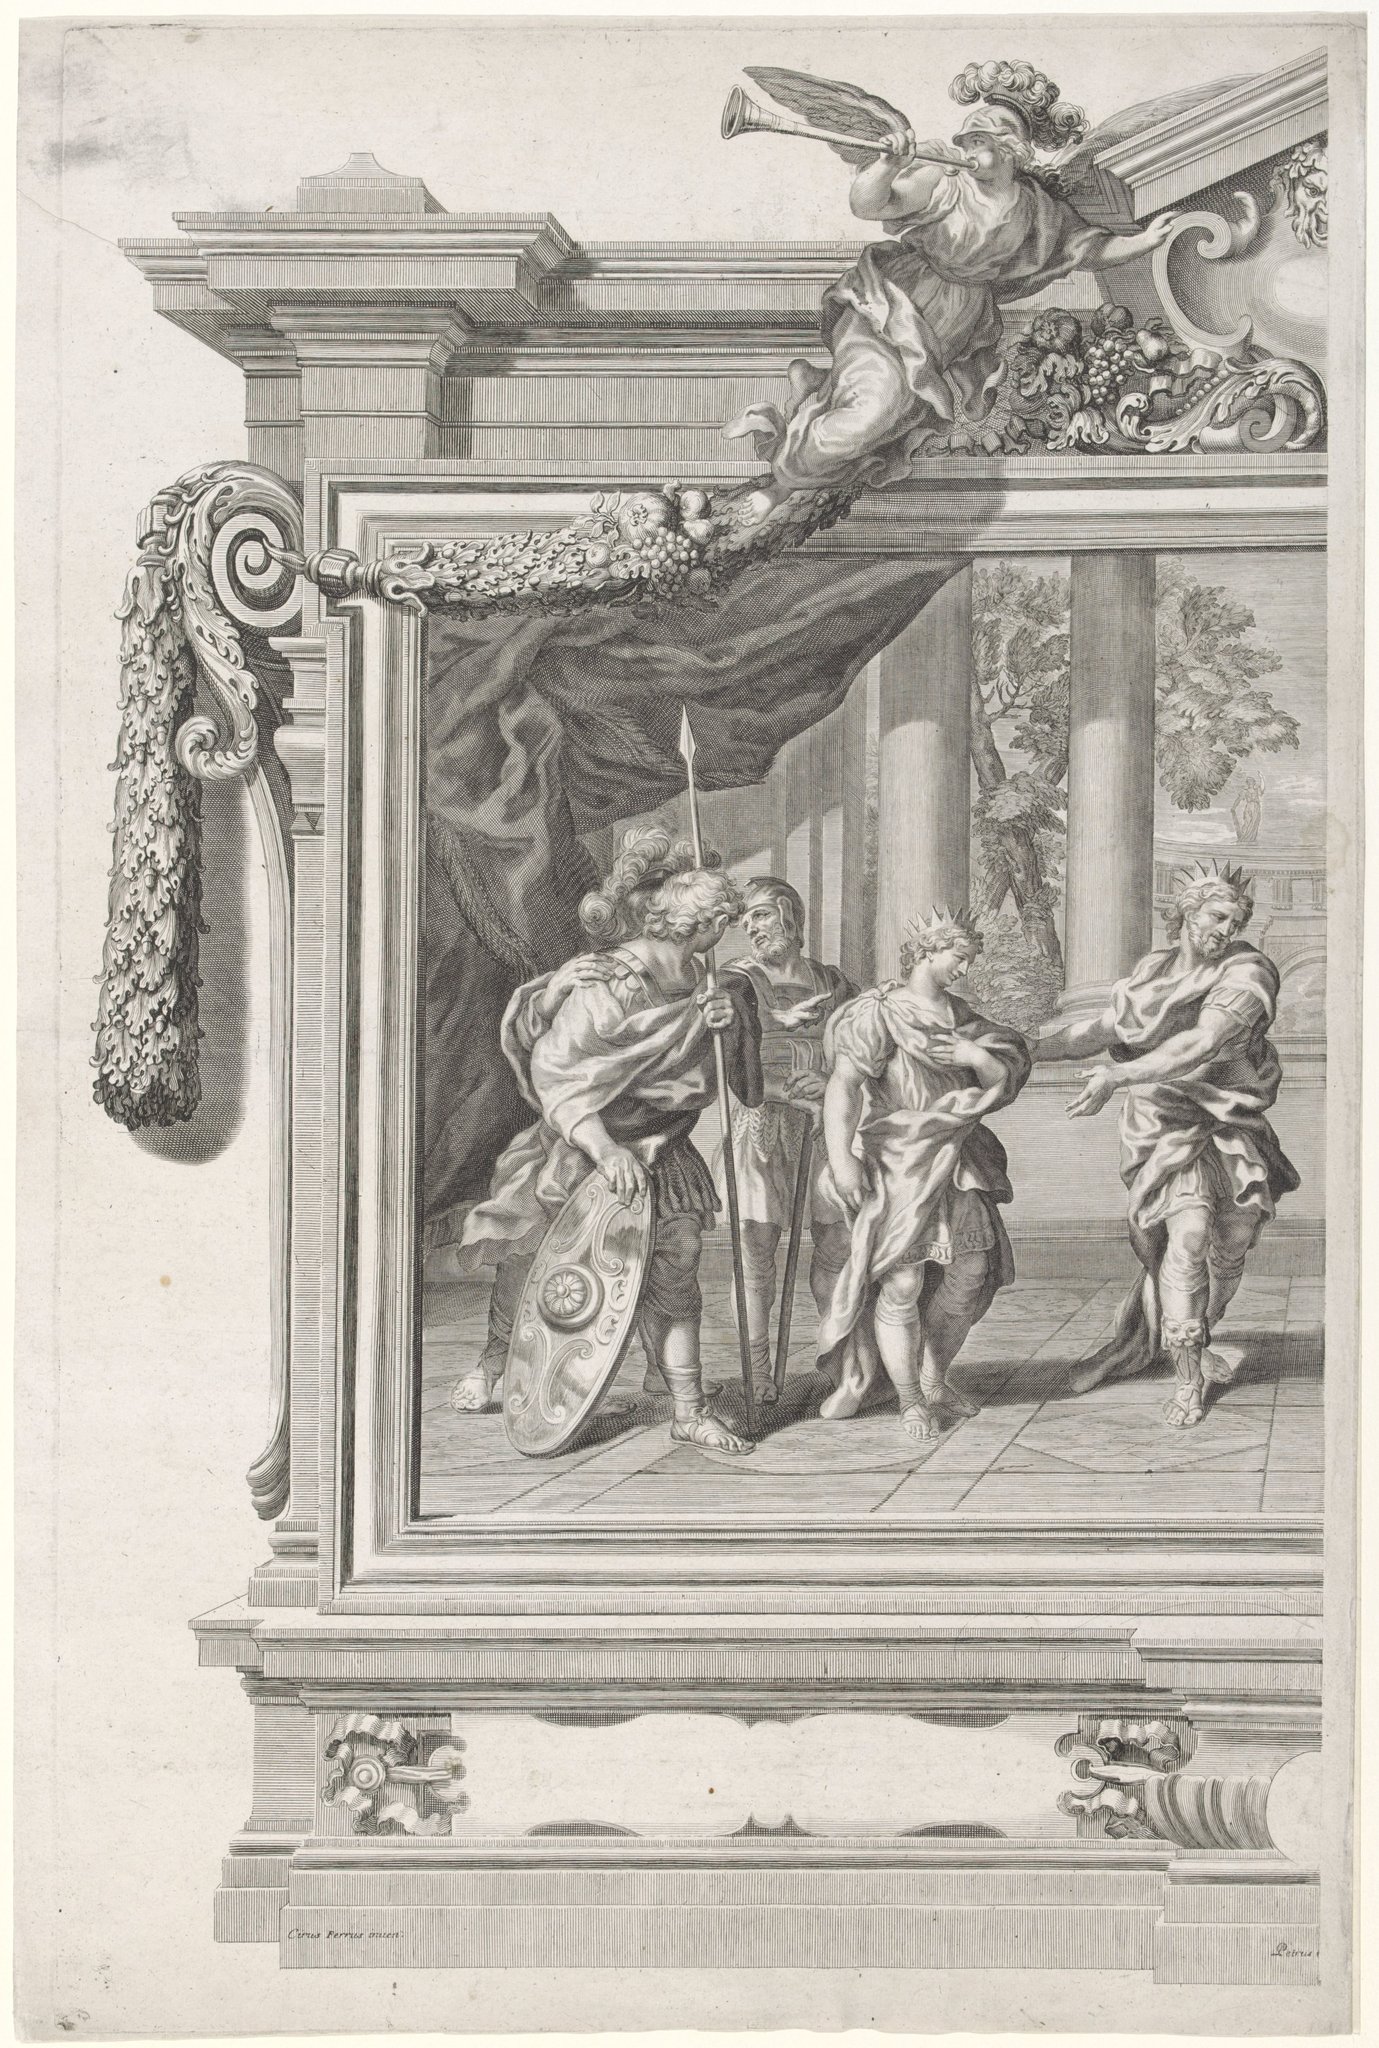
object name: print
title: Een koning presenteert zijn zoon, linkerdeel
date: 1665-1725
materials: paper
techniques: engraving, etching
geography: italy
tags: palace - aa - civic architecture: inside, wisdom; 'sapienza', 'sapienza humana', 'sapienza vera' (ripa), election, choice of a ruler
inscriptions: collector's mark: Lugt 240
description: Gezelschap onder de galerij van een paleis. De koning wijst op zijn zoon. Drie soldaten kijken toe. De voorstelling is gevat in een architecturale omlijsting, bekroond met een timpaan. Wijsheid blaast de bazuin. Onderaan een leeg cartouche.